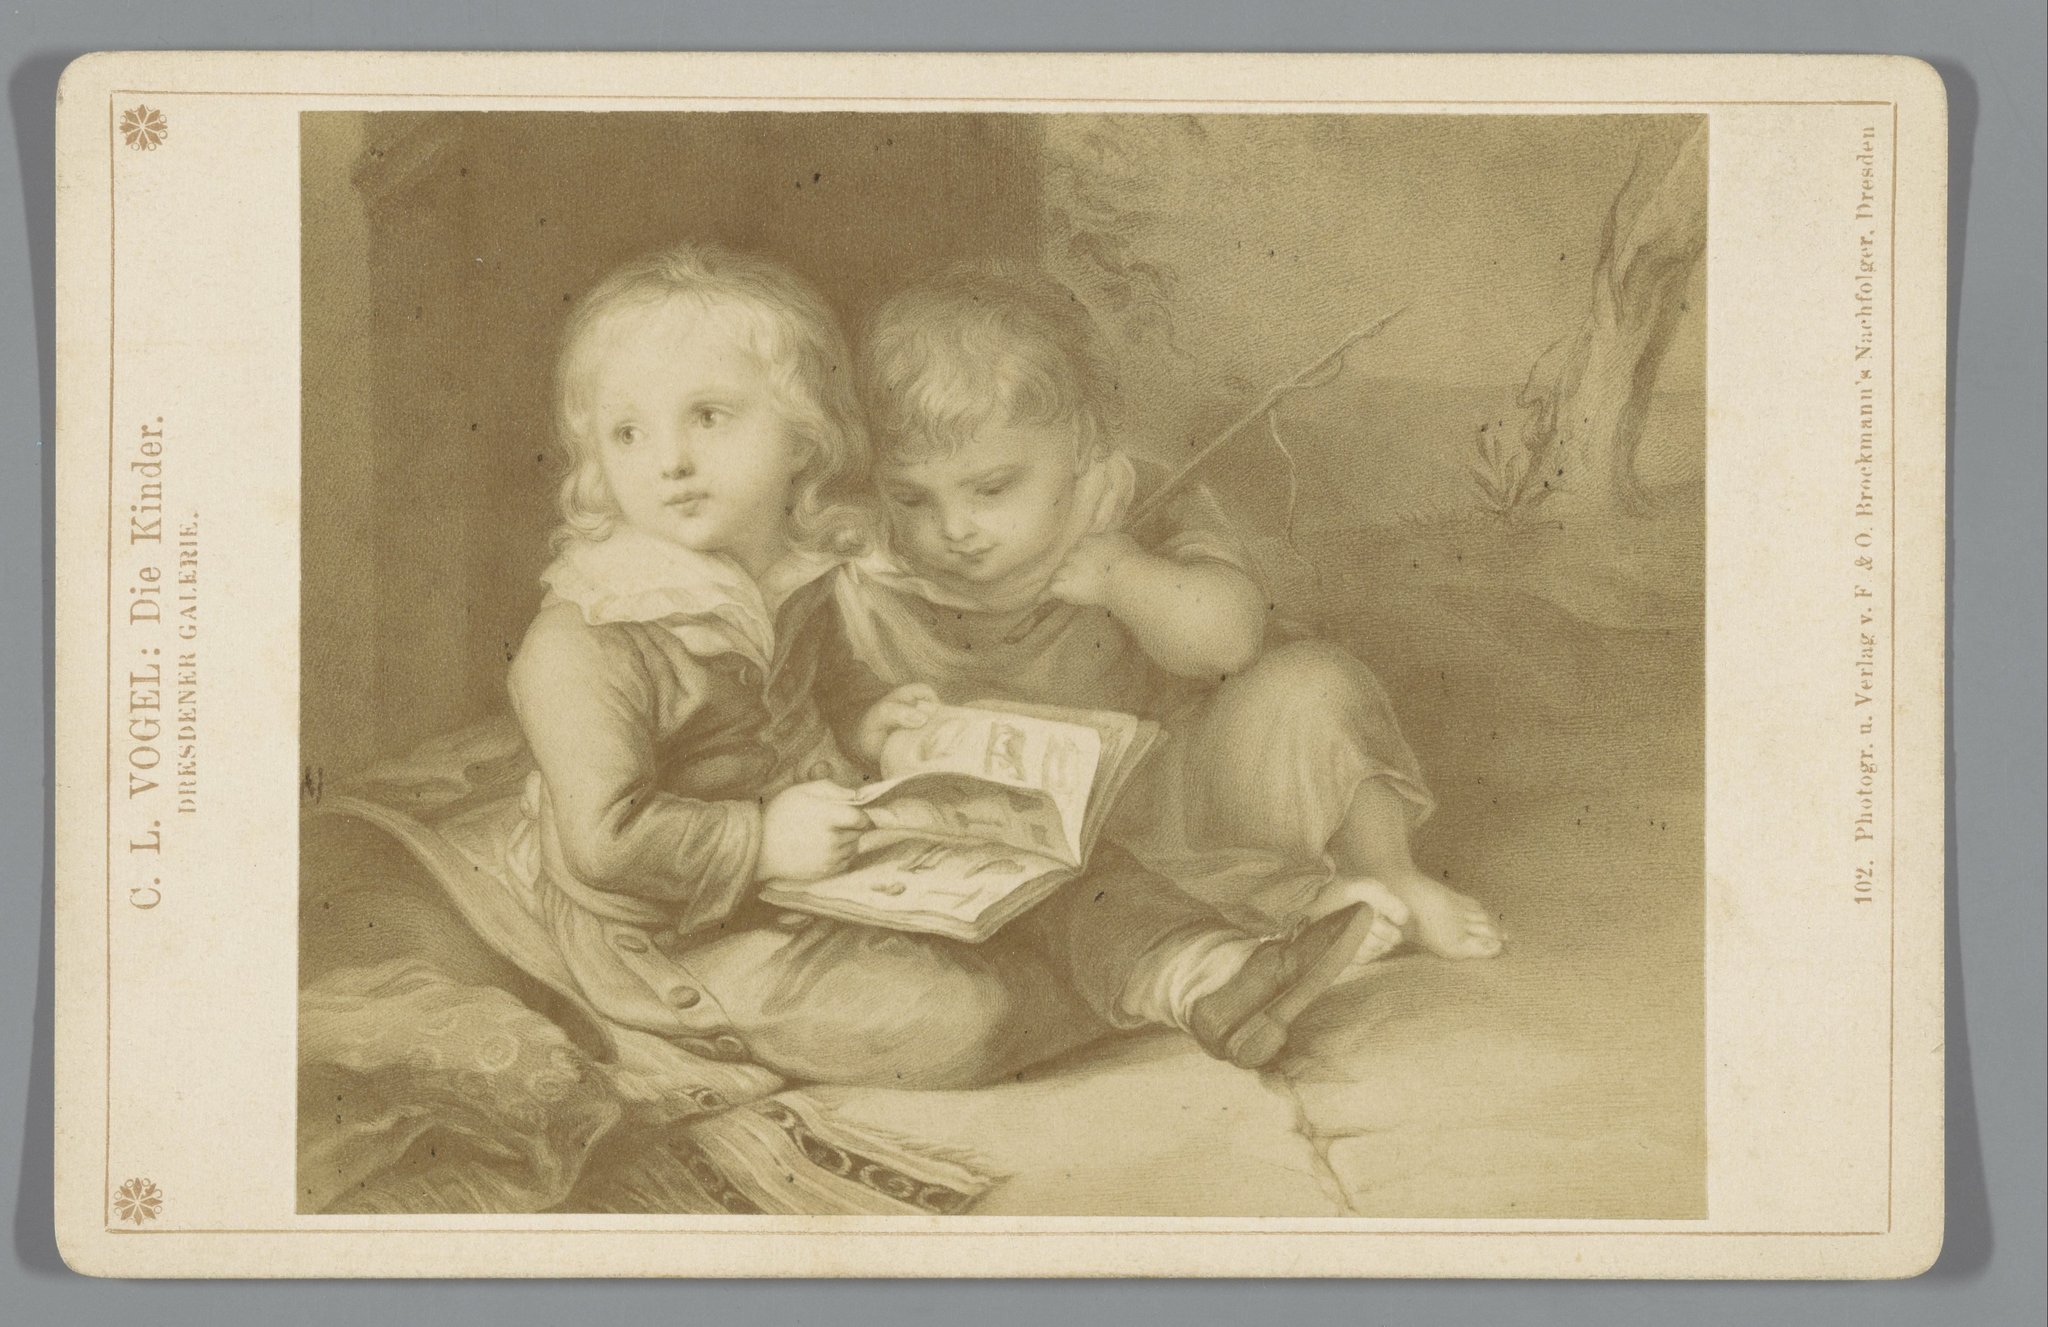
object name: reproduction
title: C.L. Vogel: Die Kinder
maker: christian leberecht vogel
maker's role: painter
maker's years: 1759-1816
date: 1870-1890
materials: cardboard, paper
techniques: albumen print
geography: dresden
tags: child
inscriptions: collector's mark: ‘Vosmaer’